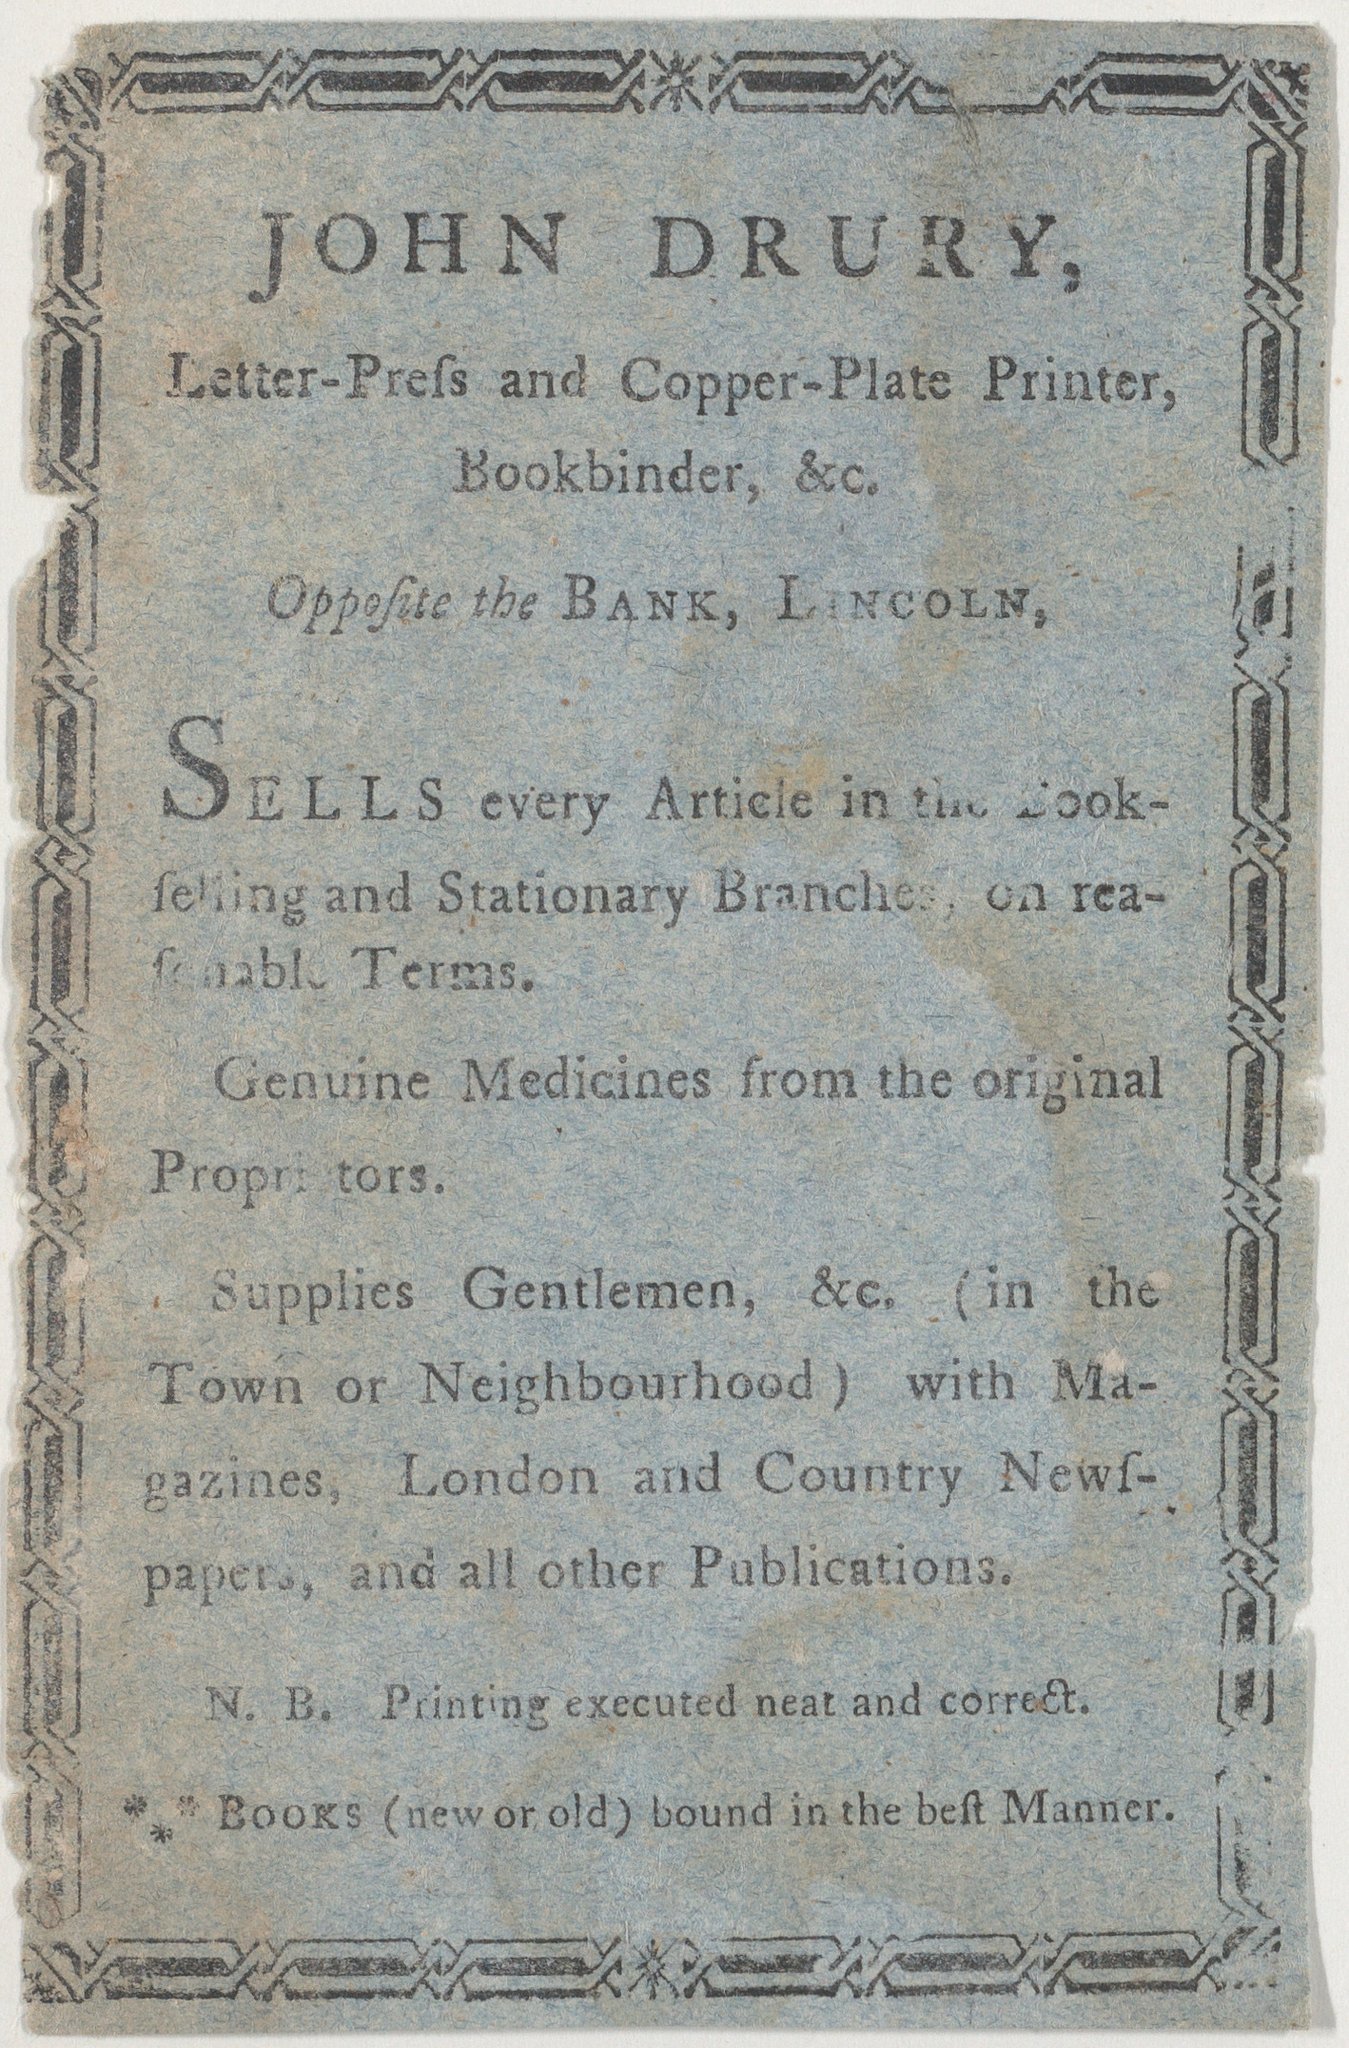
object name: print, trade card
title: Trade Card for John Drury, printer and bookbinder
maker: anonymous, british, 18th century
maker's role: artist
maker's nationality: british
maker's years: 1700-1800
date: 1701-1800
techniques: lithograph